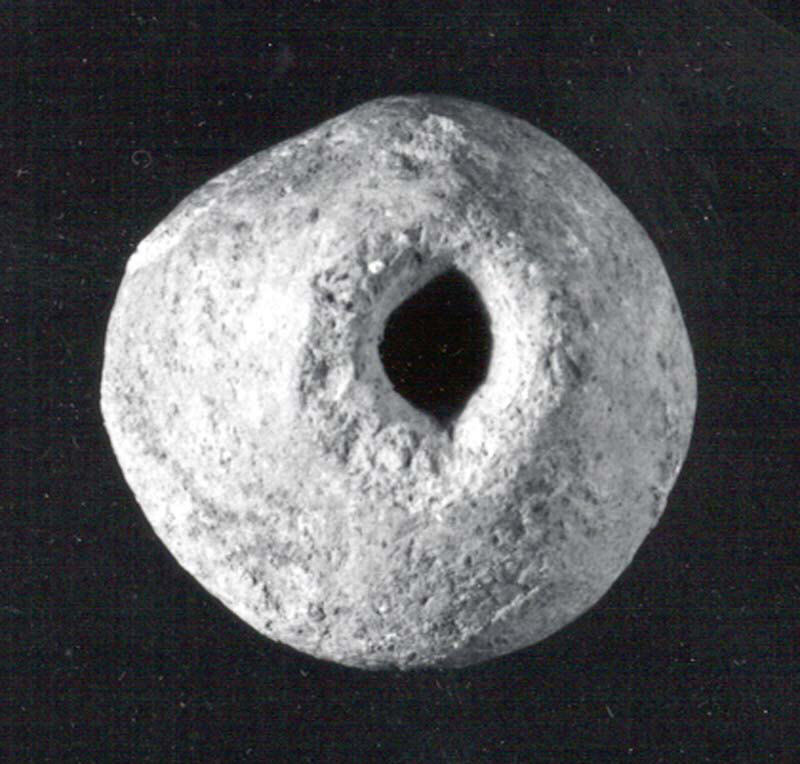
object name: whorl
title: Spindle whorl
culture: iranian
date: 5000-2001 BCE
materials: ceramic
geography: iran